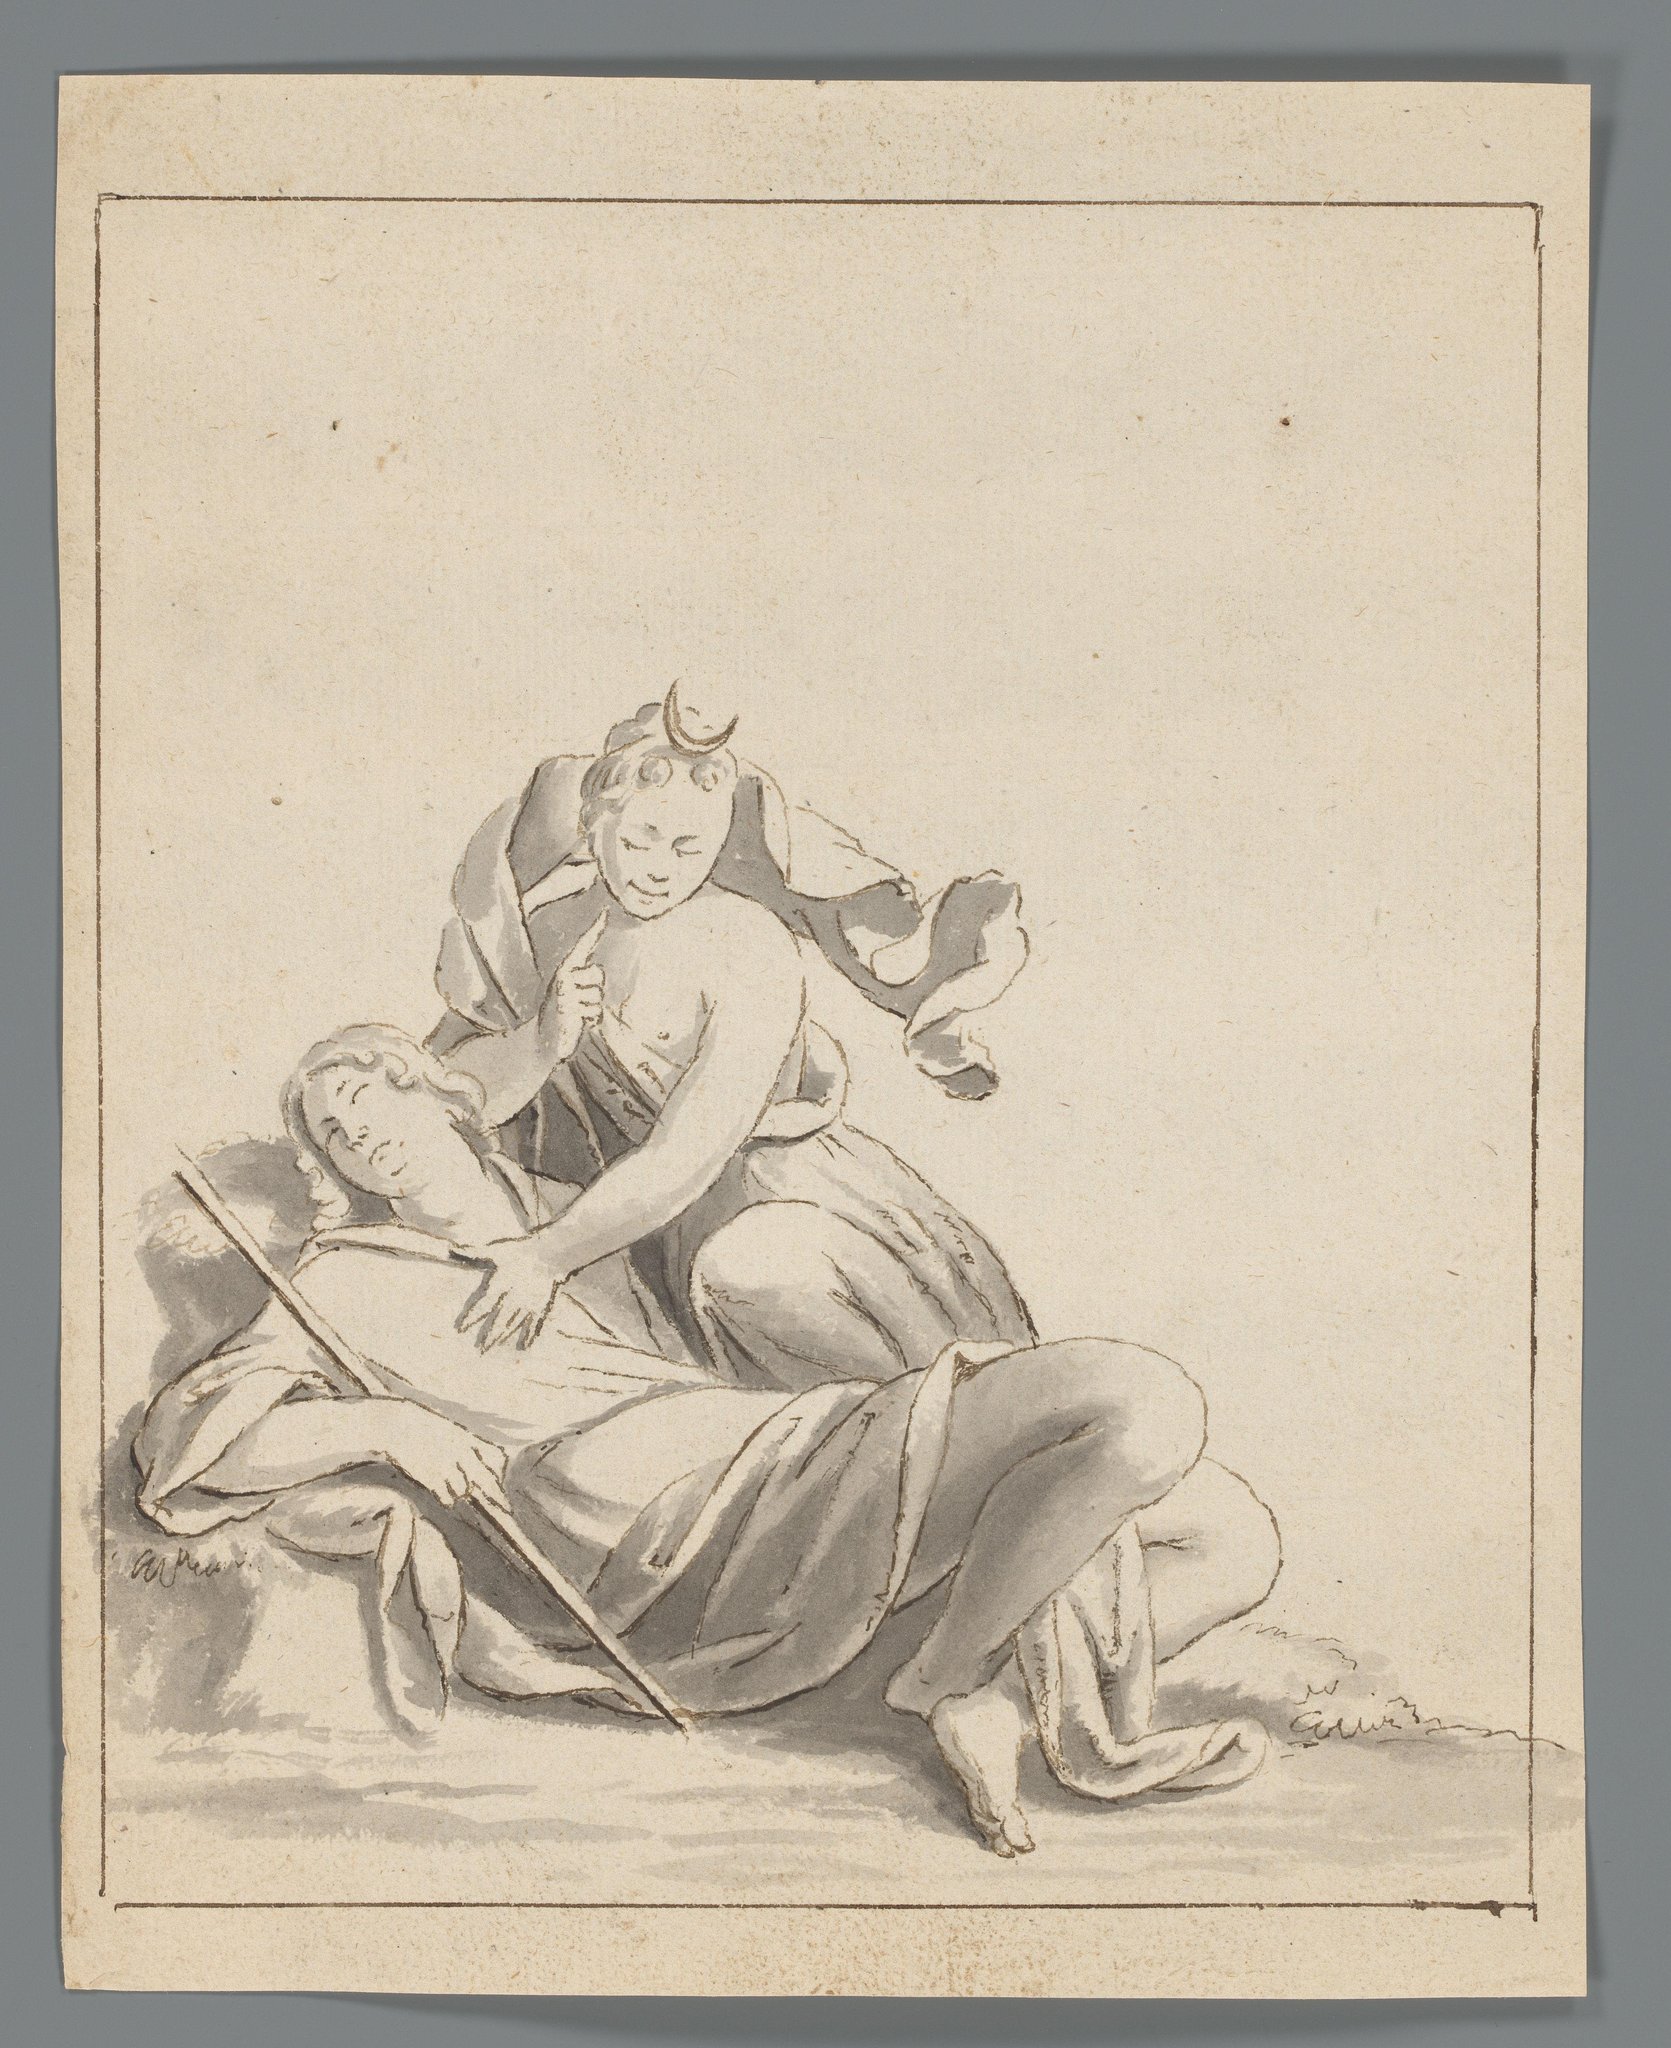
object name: drawing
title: Diana en Endymion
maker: matthijs balen (1684-1766)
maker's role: draughtsman, painter, print maker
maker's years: 1684-1766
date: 1694-1766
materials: paper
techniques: brush, pen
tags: diana (luna) visiting the sleeping endymion